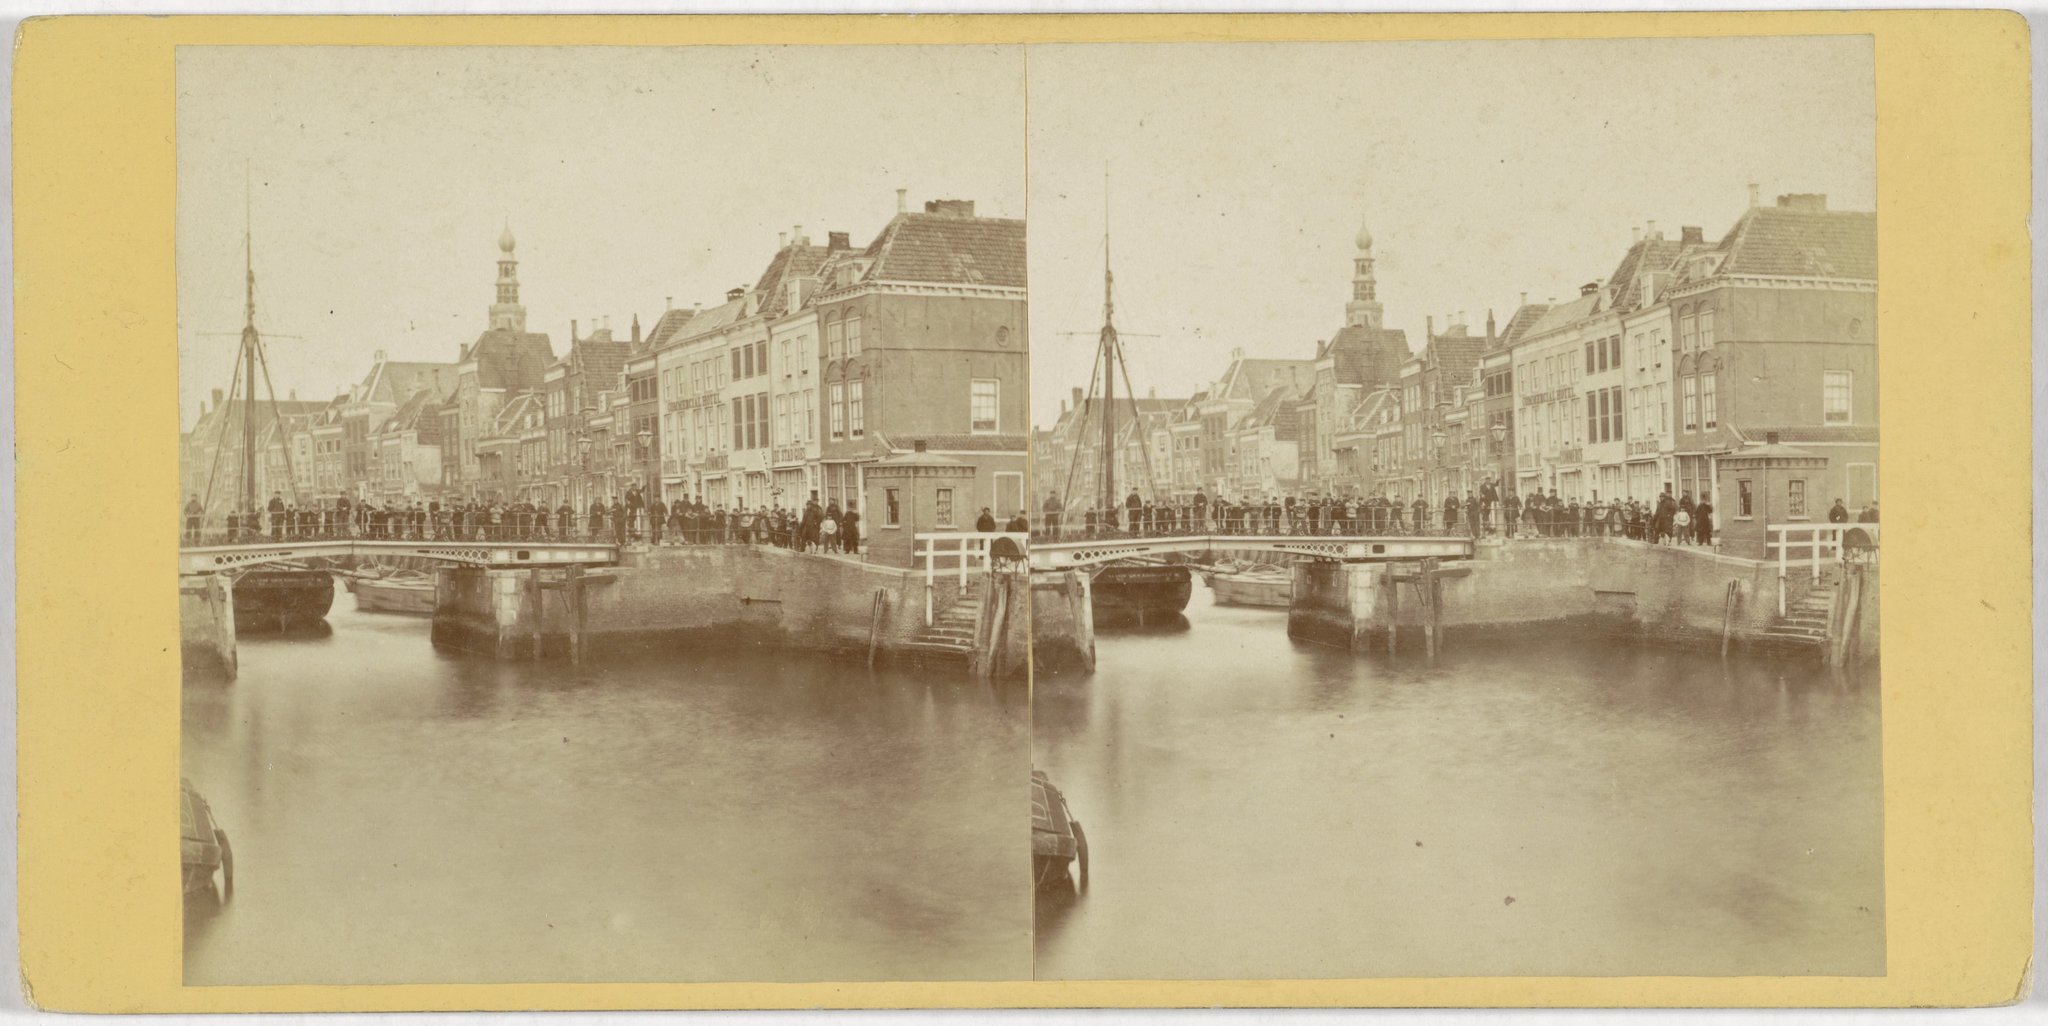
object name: stereograph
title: Spaansche kade te Rotterdam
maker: Anonymous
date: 1861-1870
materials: cardboard, paper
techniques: albumen print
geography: flushing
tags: city-view in general; 'veduta', canals, waters (in city)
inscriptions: inscription: ‘50’, inscription: ‘Middelburg? MB’